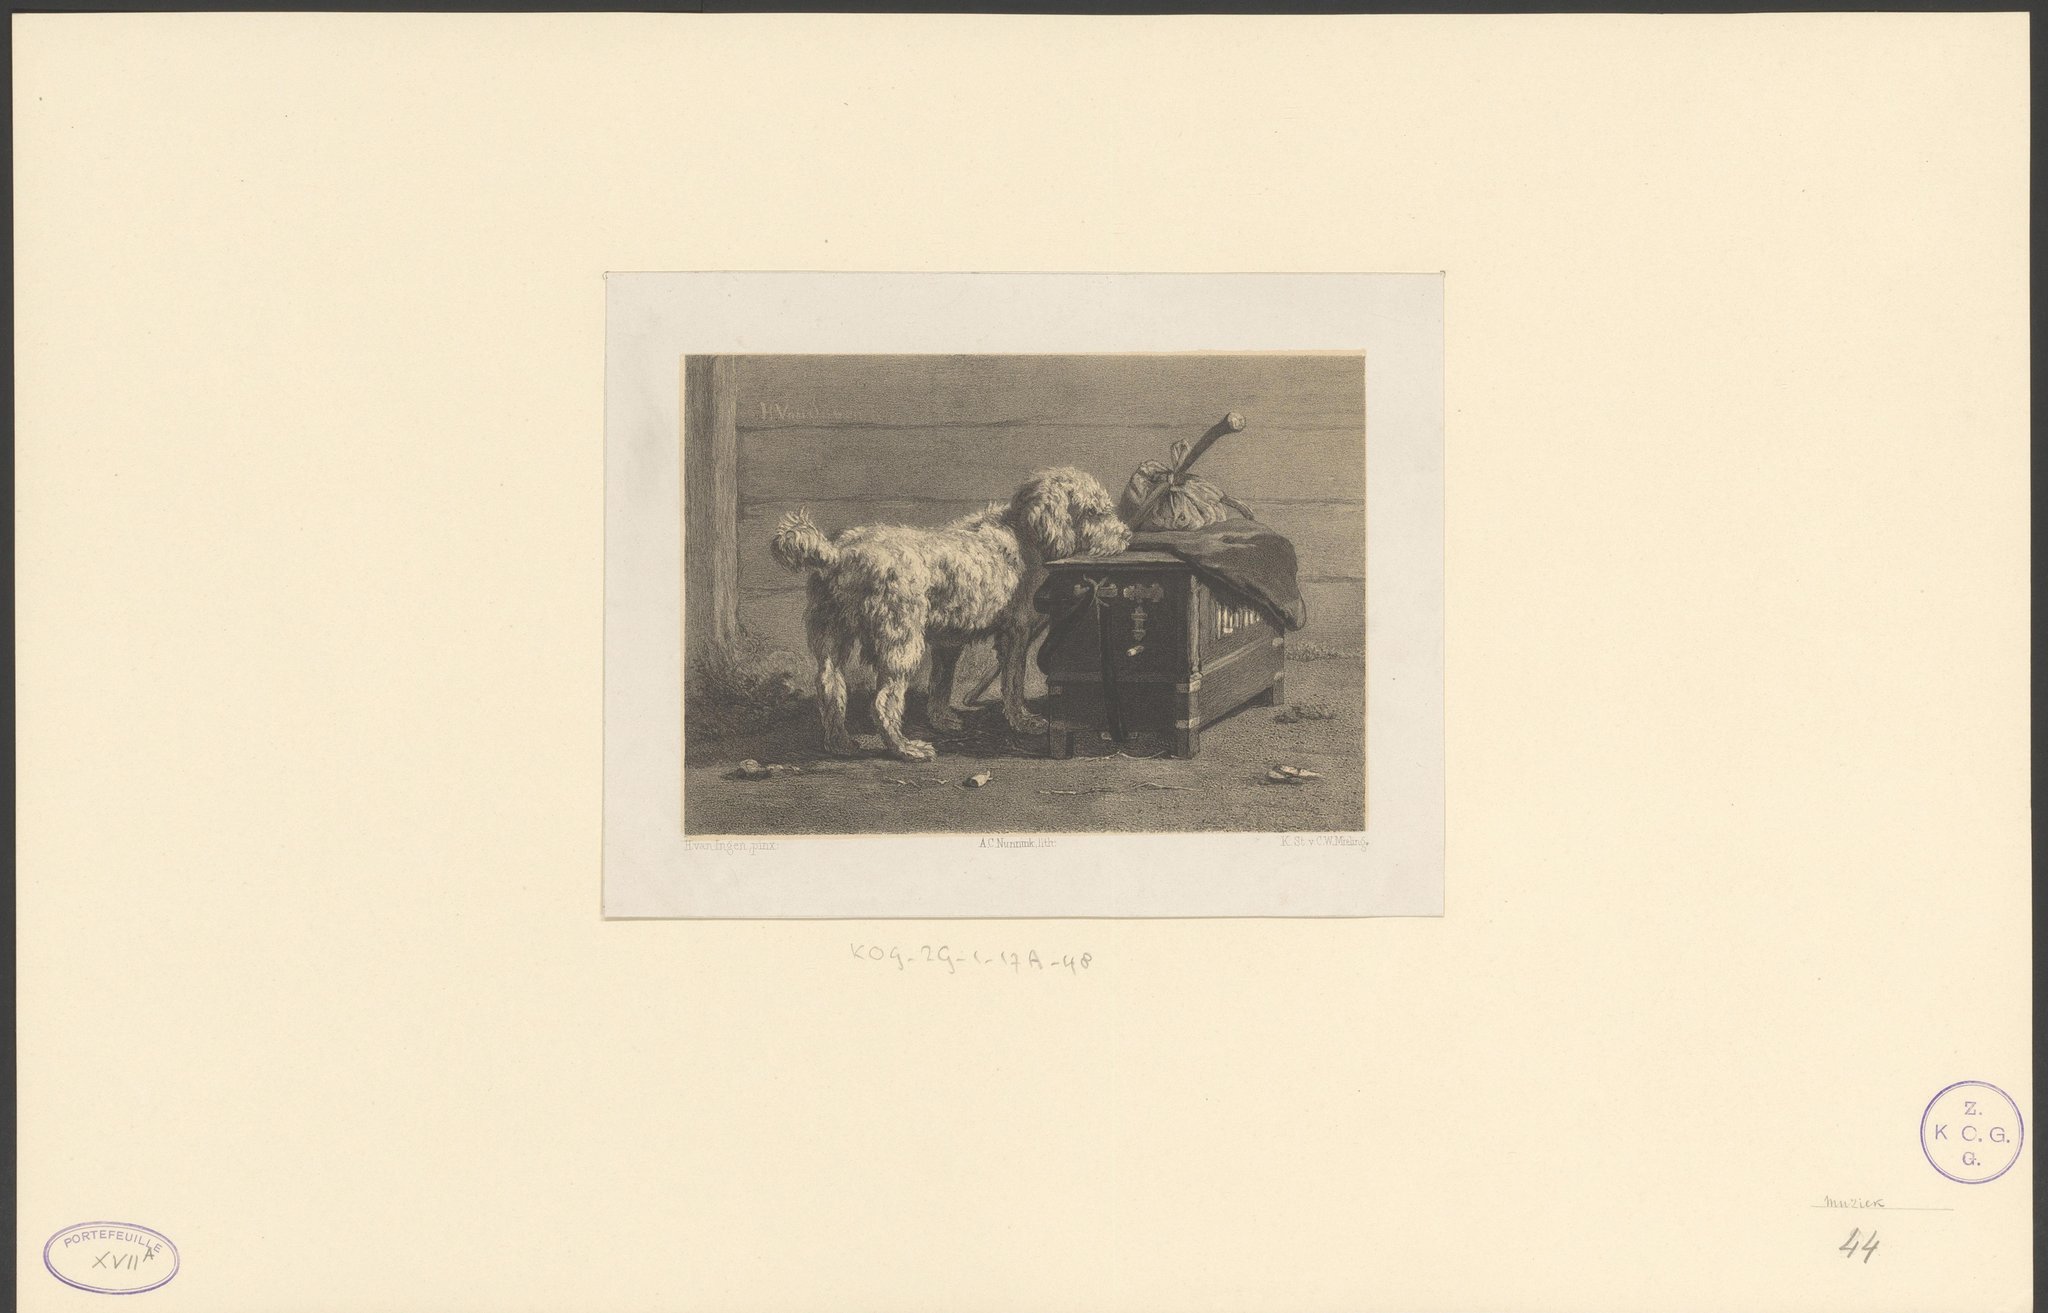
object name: print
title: Straatorgel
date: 1847-1865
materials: paper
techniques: tone lithography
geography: netherlands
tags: instruments ~ popular music, barrel-organ player, knapsack, rucksack, dog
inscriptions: collector's mark, collector's mark: Lugt 1641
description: Een hond bij een op de grond staande straatorgel. Een knapzak aan een stok staat tegen het orgel geleund. Onderwerpsrubrieken binnen de Atlas Zeden en Gewoonten: Muziek en muziekinstrumenten: Liereman en straatorgels.